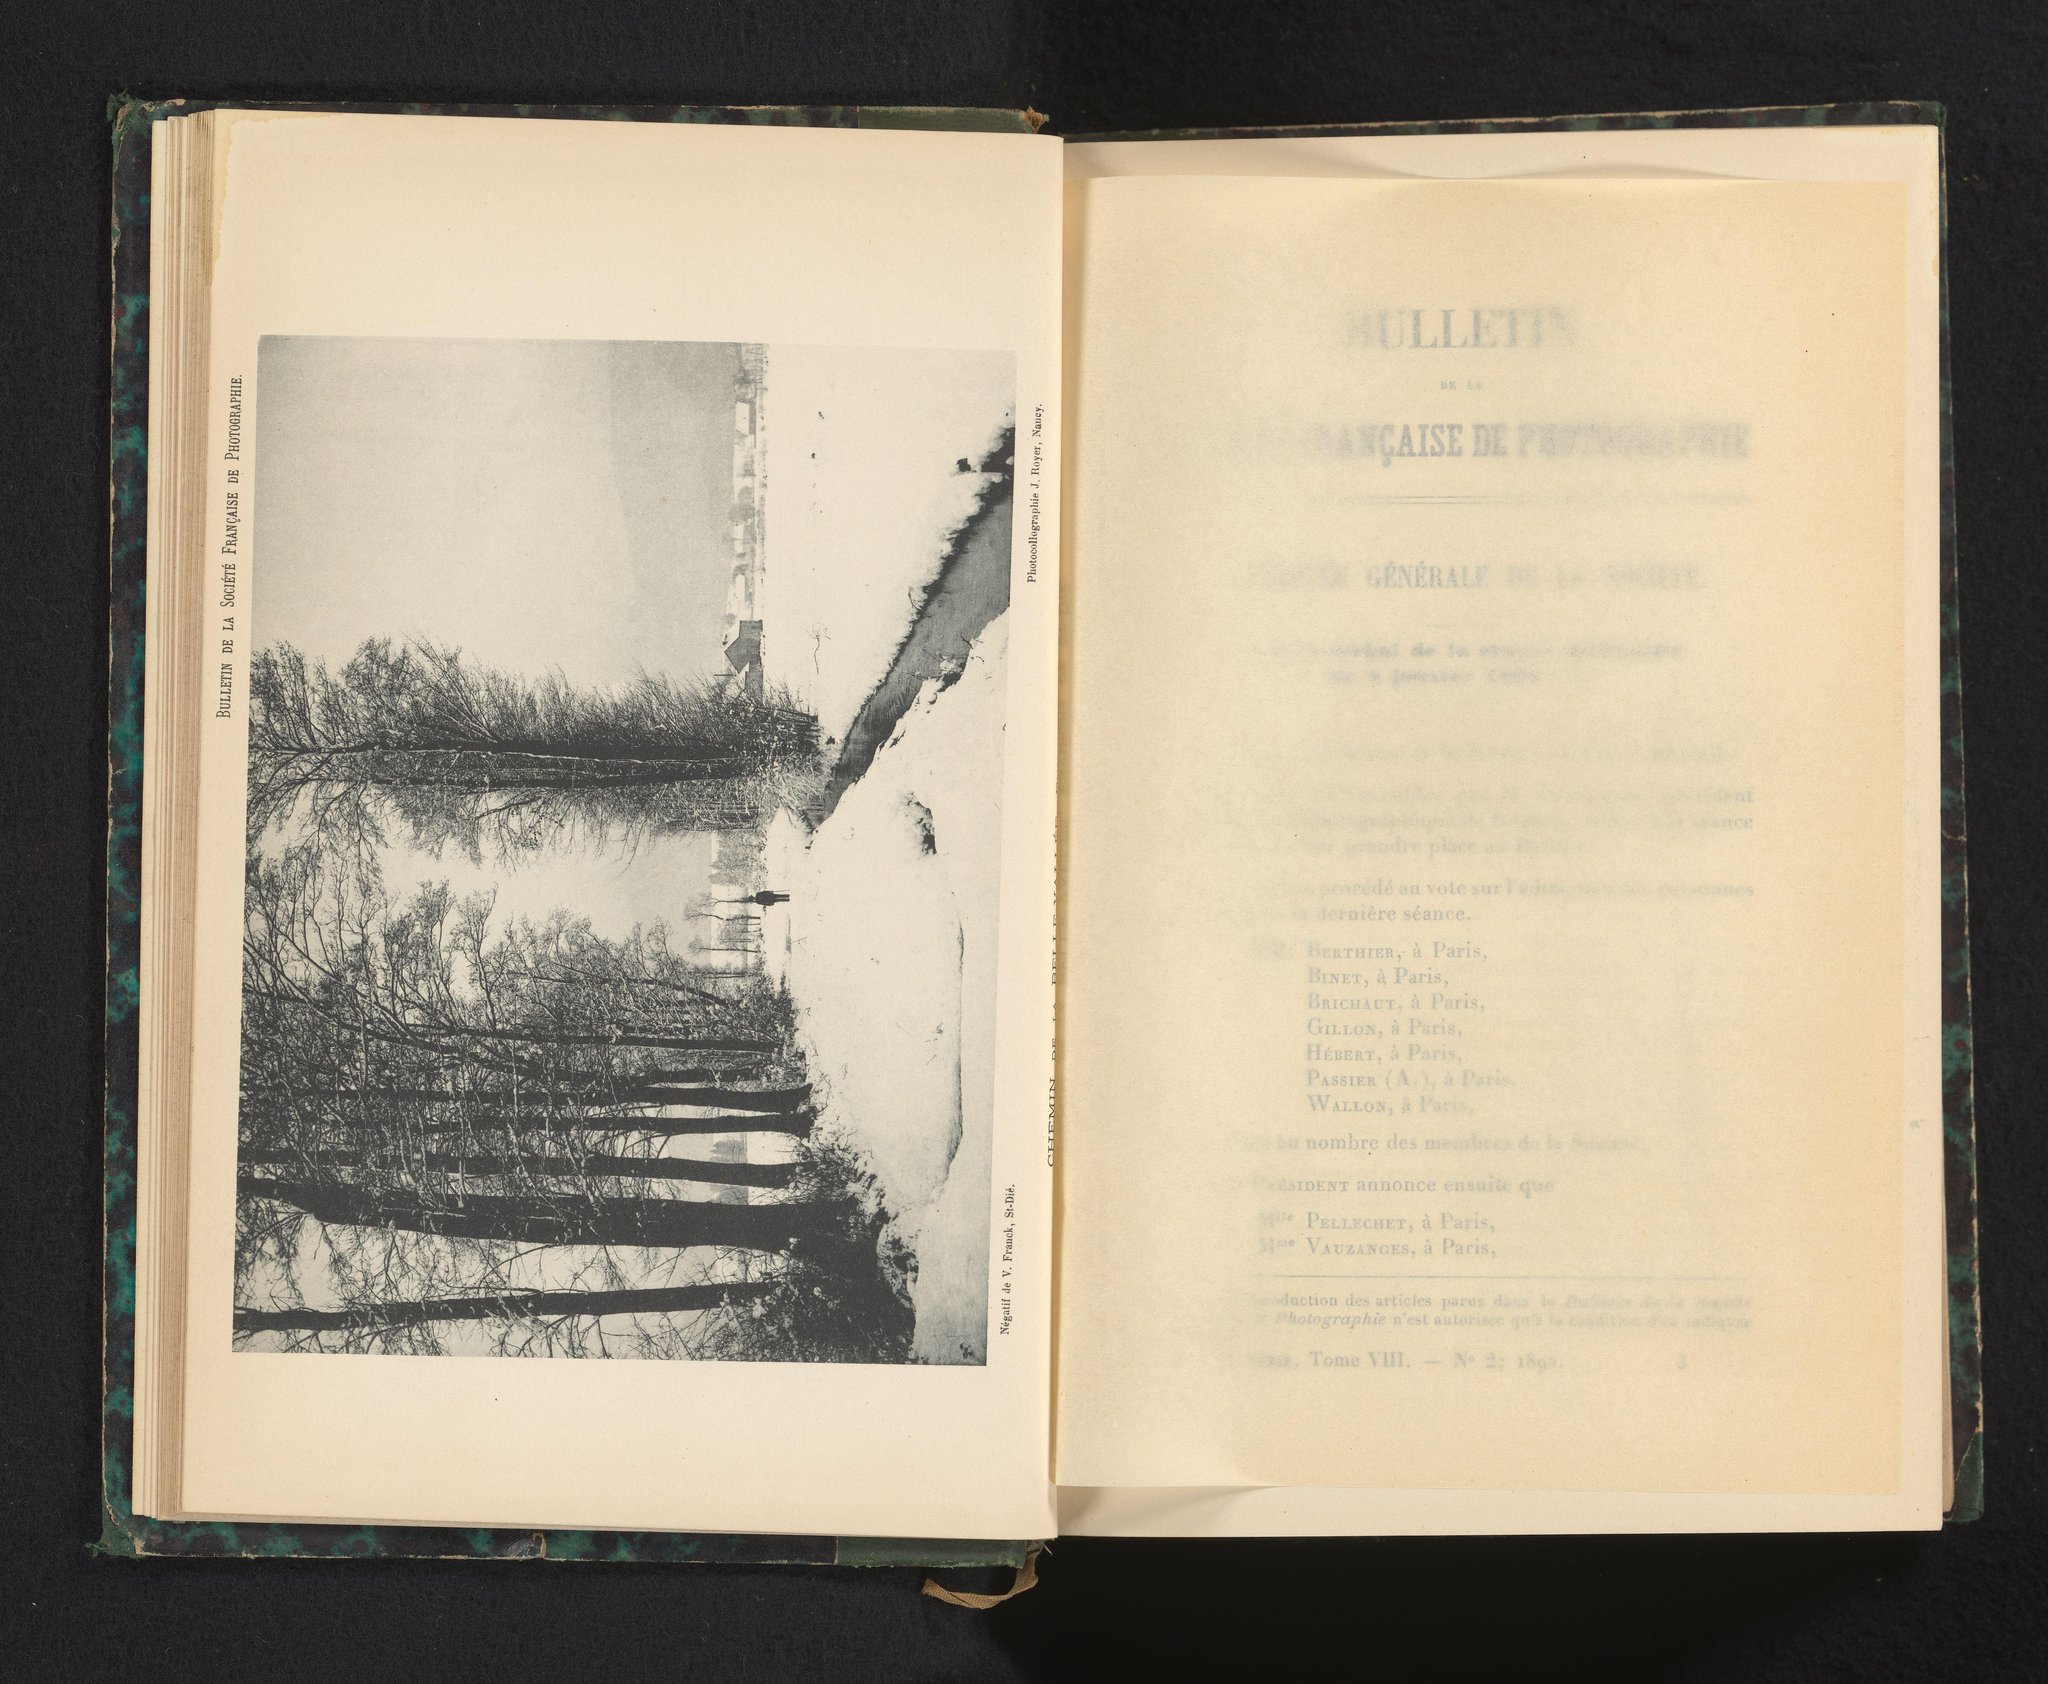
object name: photomechanical print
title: Chemin de la Belle-Vallée, environs de St-Dié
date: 1886-1891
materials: paper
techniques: photograph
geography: nancy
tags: snow